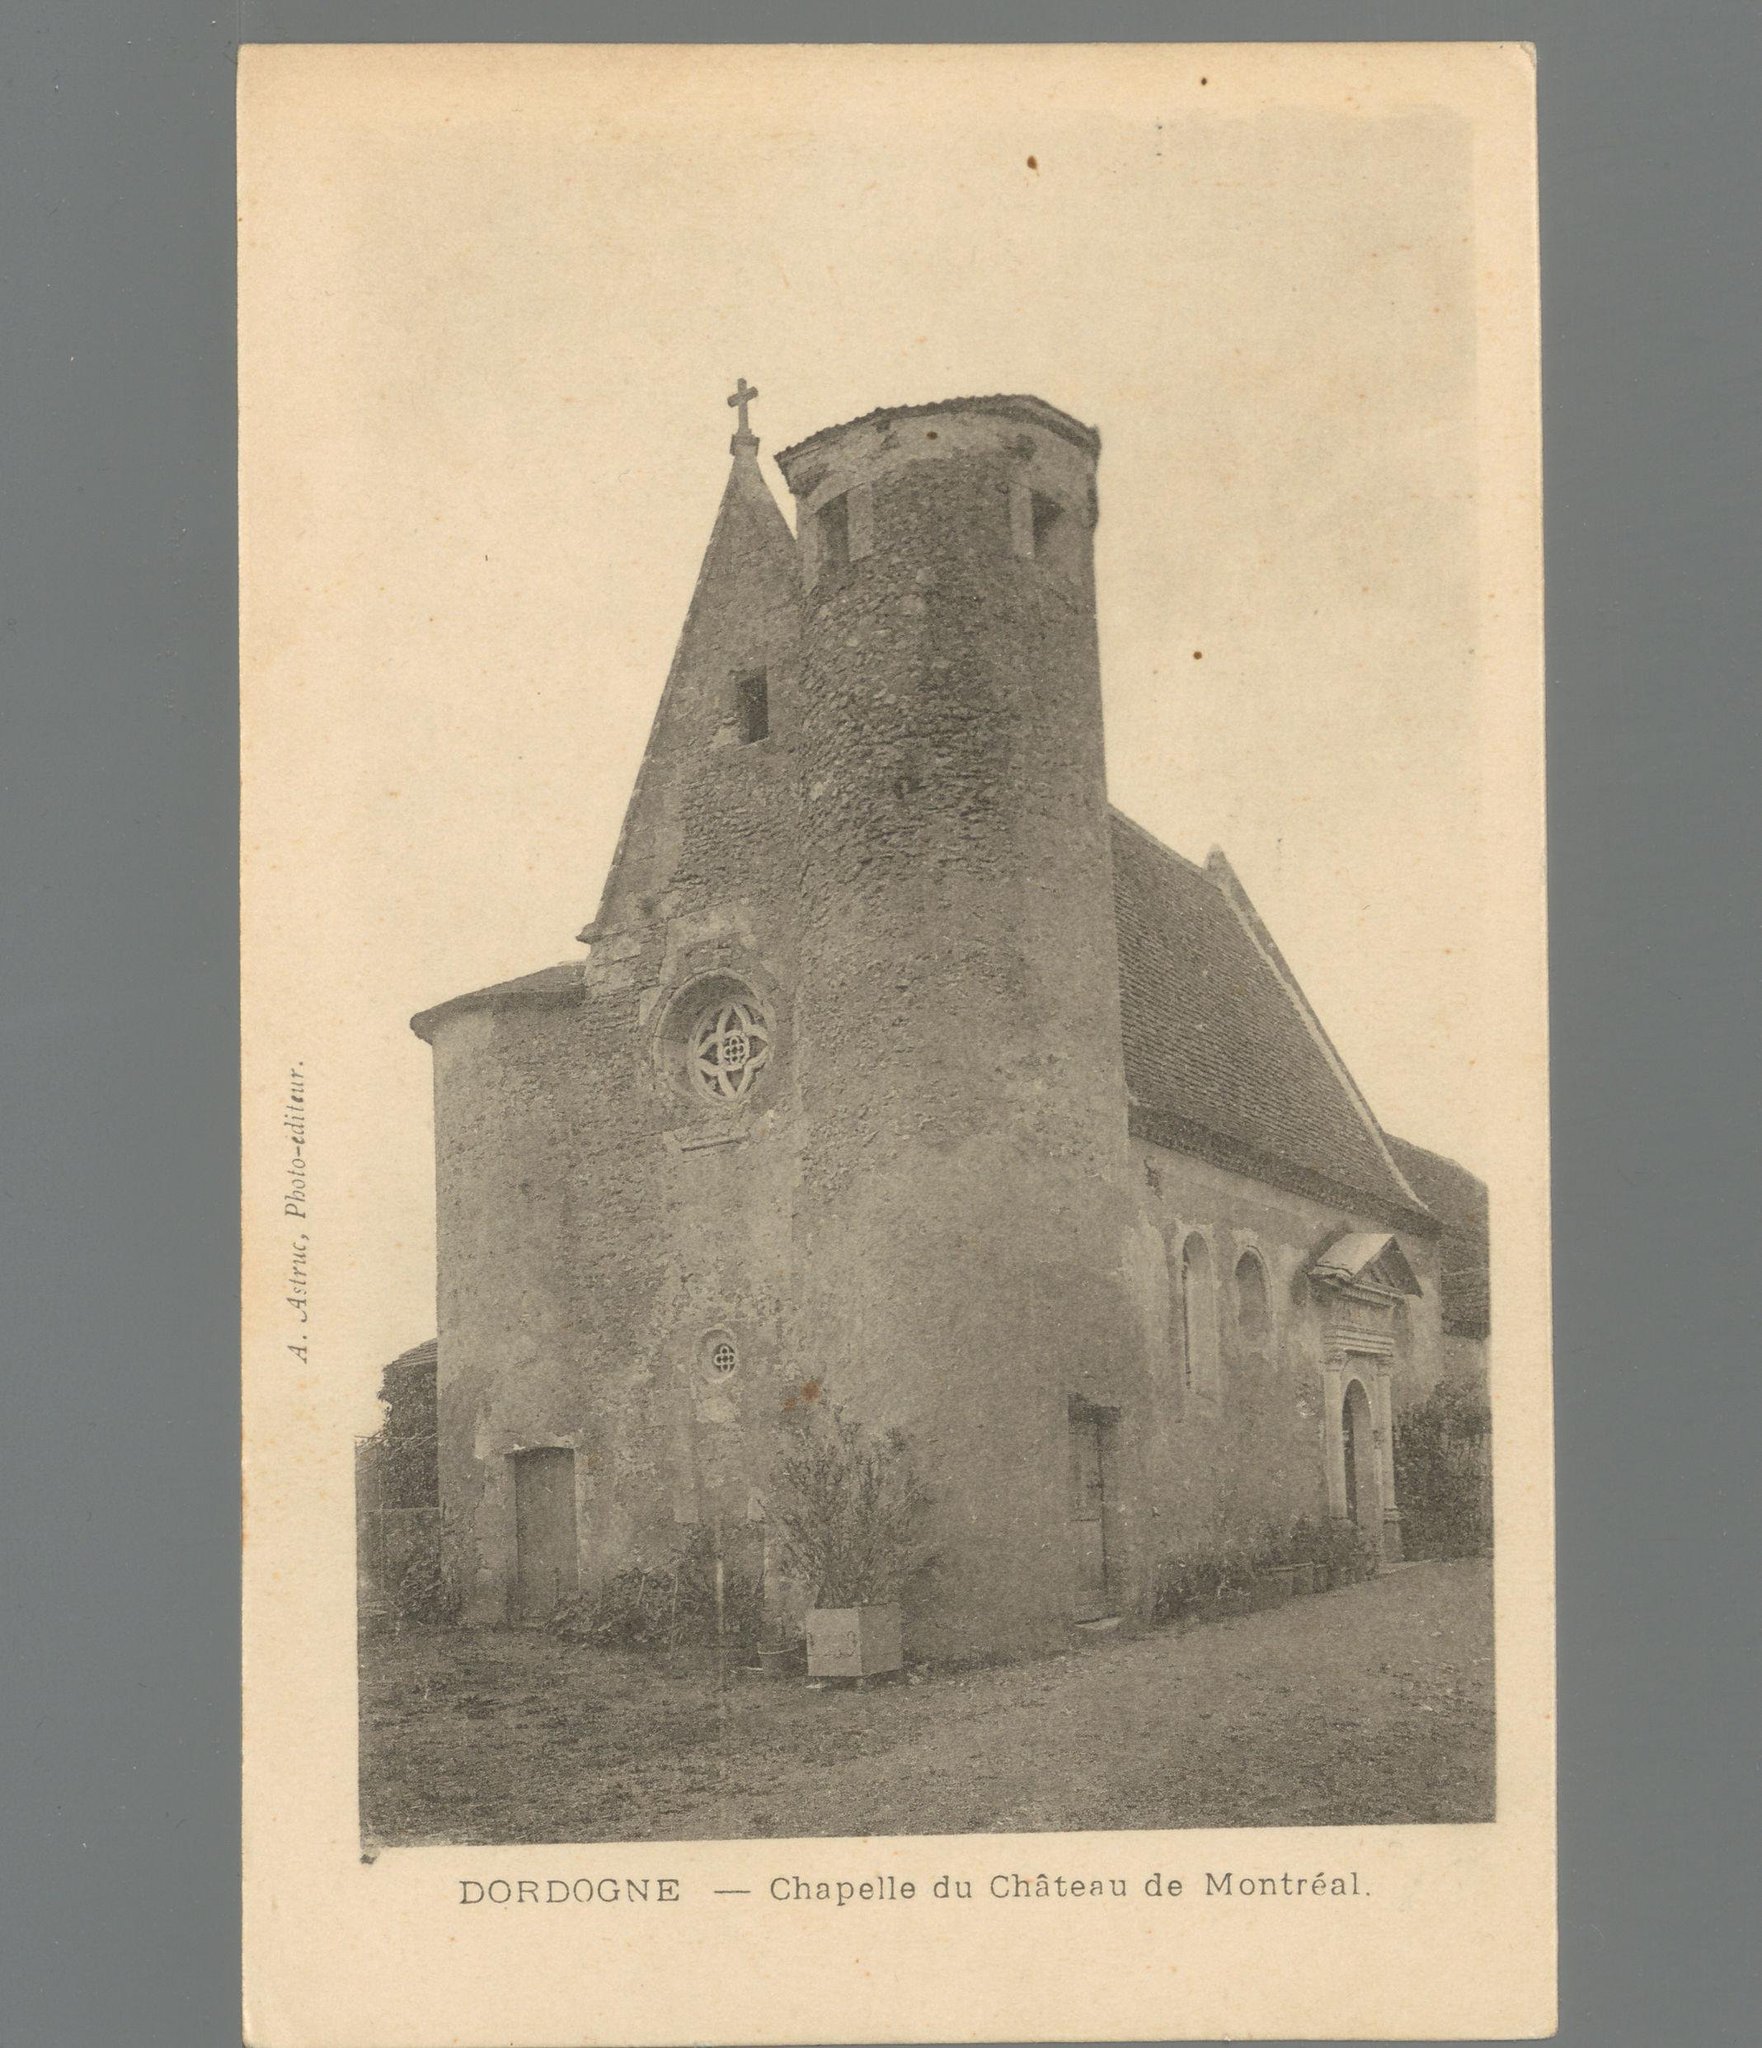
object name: photomechanical print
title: Dordogne. Chapelle du Château de Montréal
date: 1892-1904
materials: cardboard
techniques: photograph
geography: issac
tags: church (exterior)